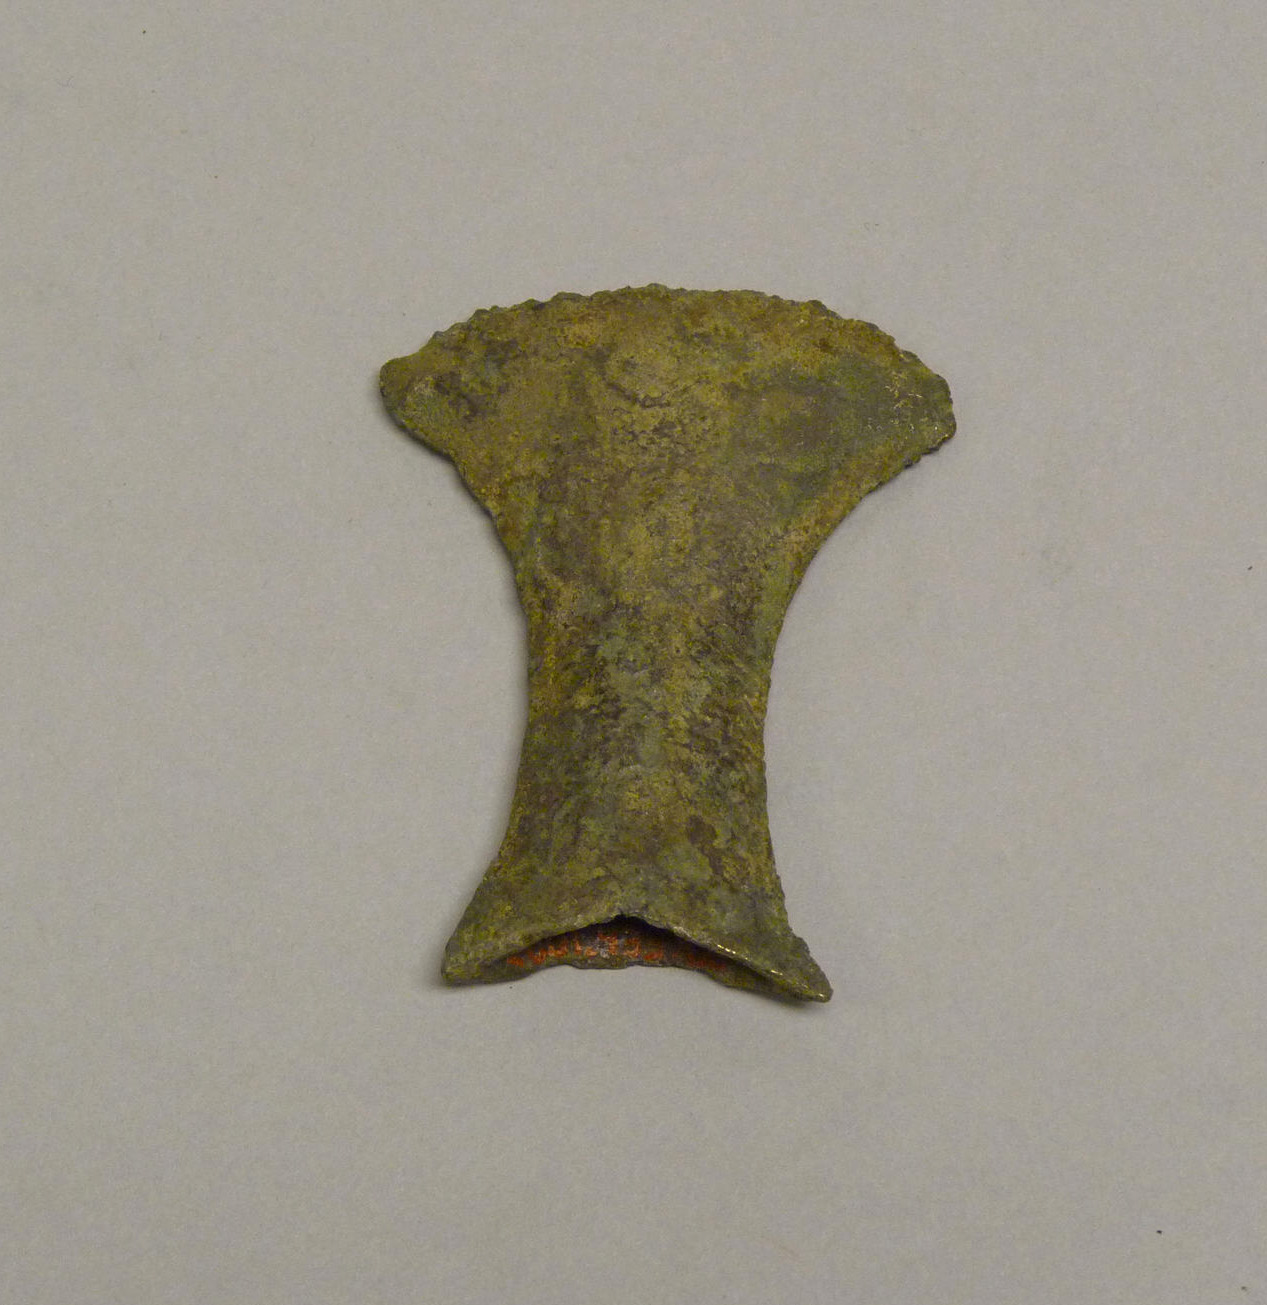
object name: hafted ax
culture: indonesian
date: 500 BCE-300 CE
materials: bronze